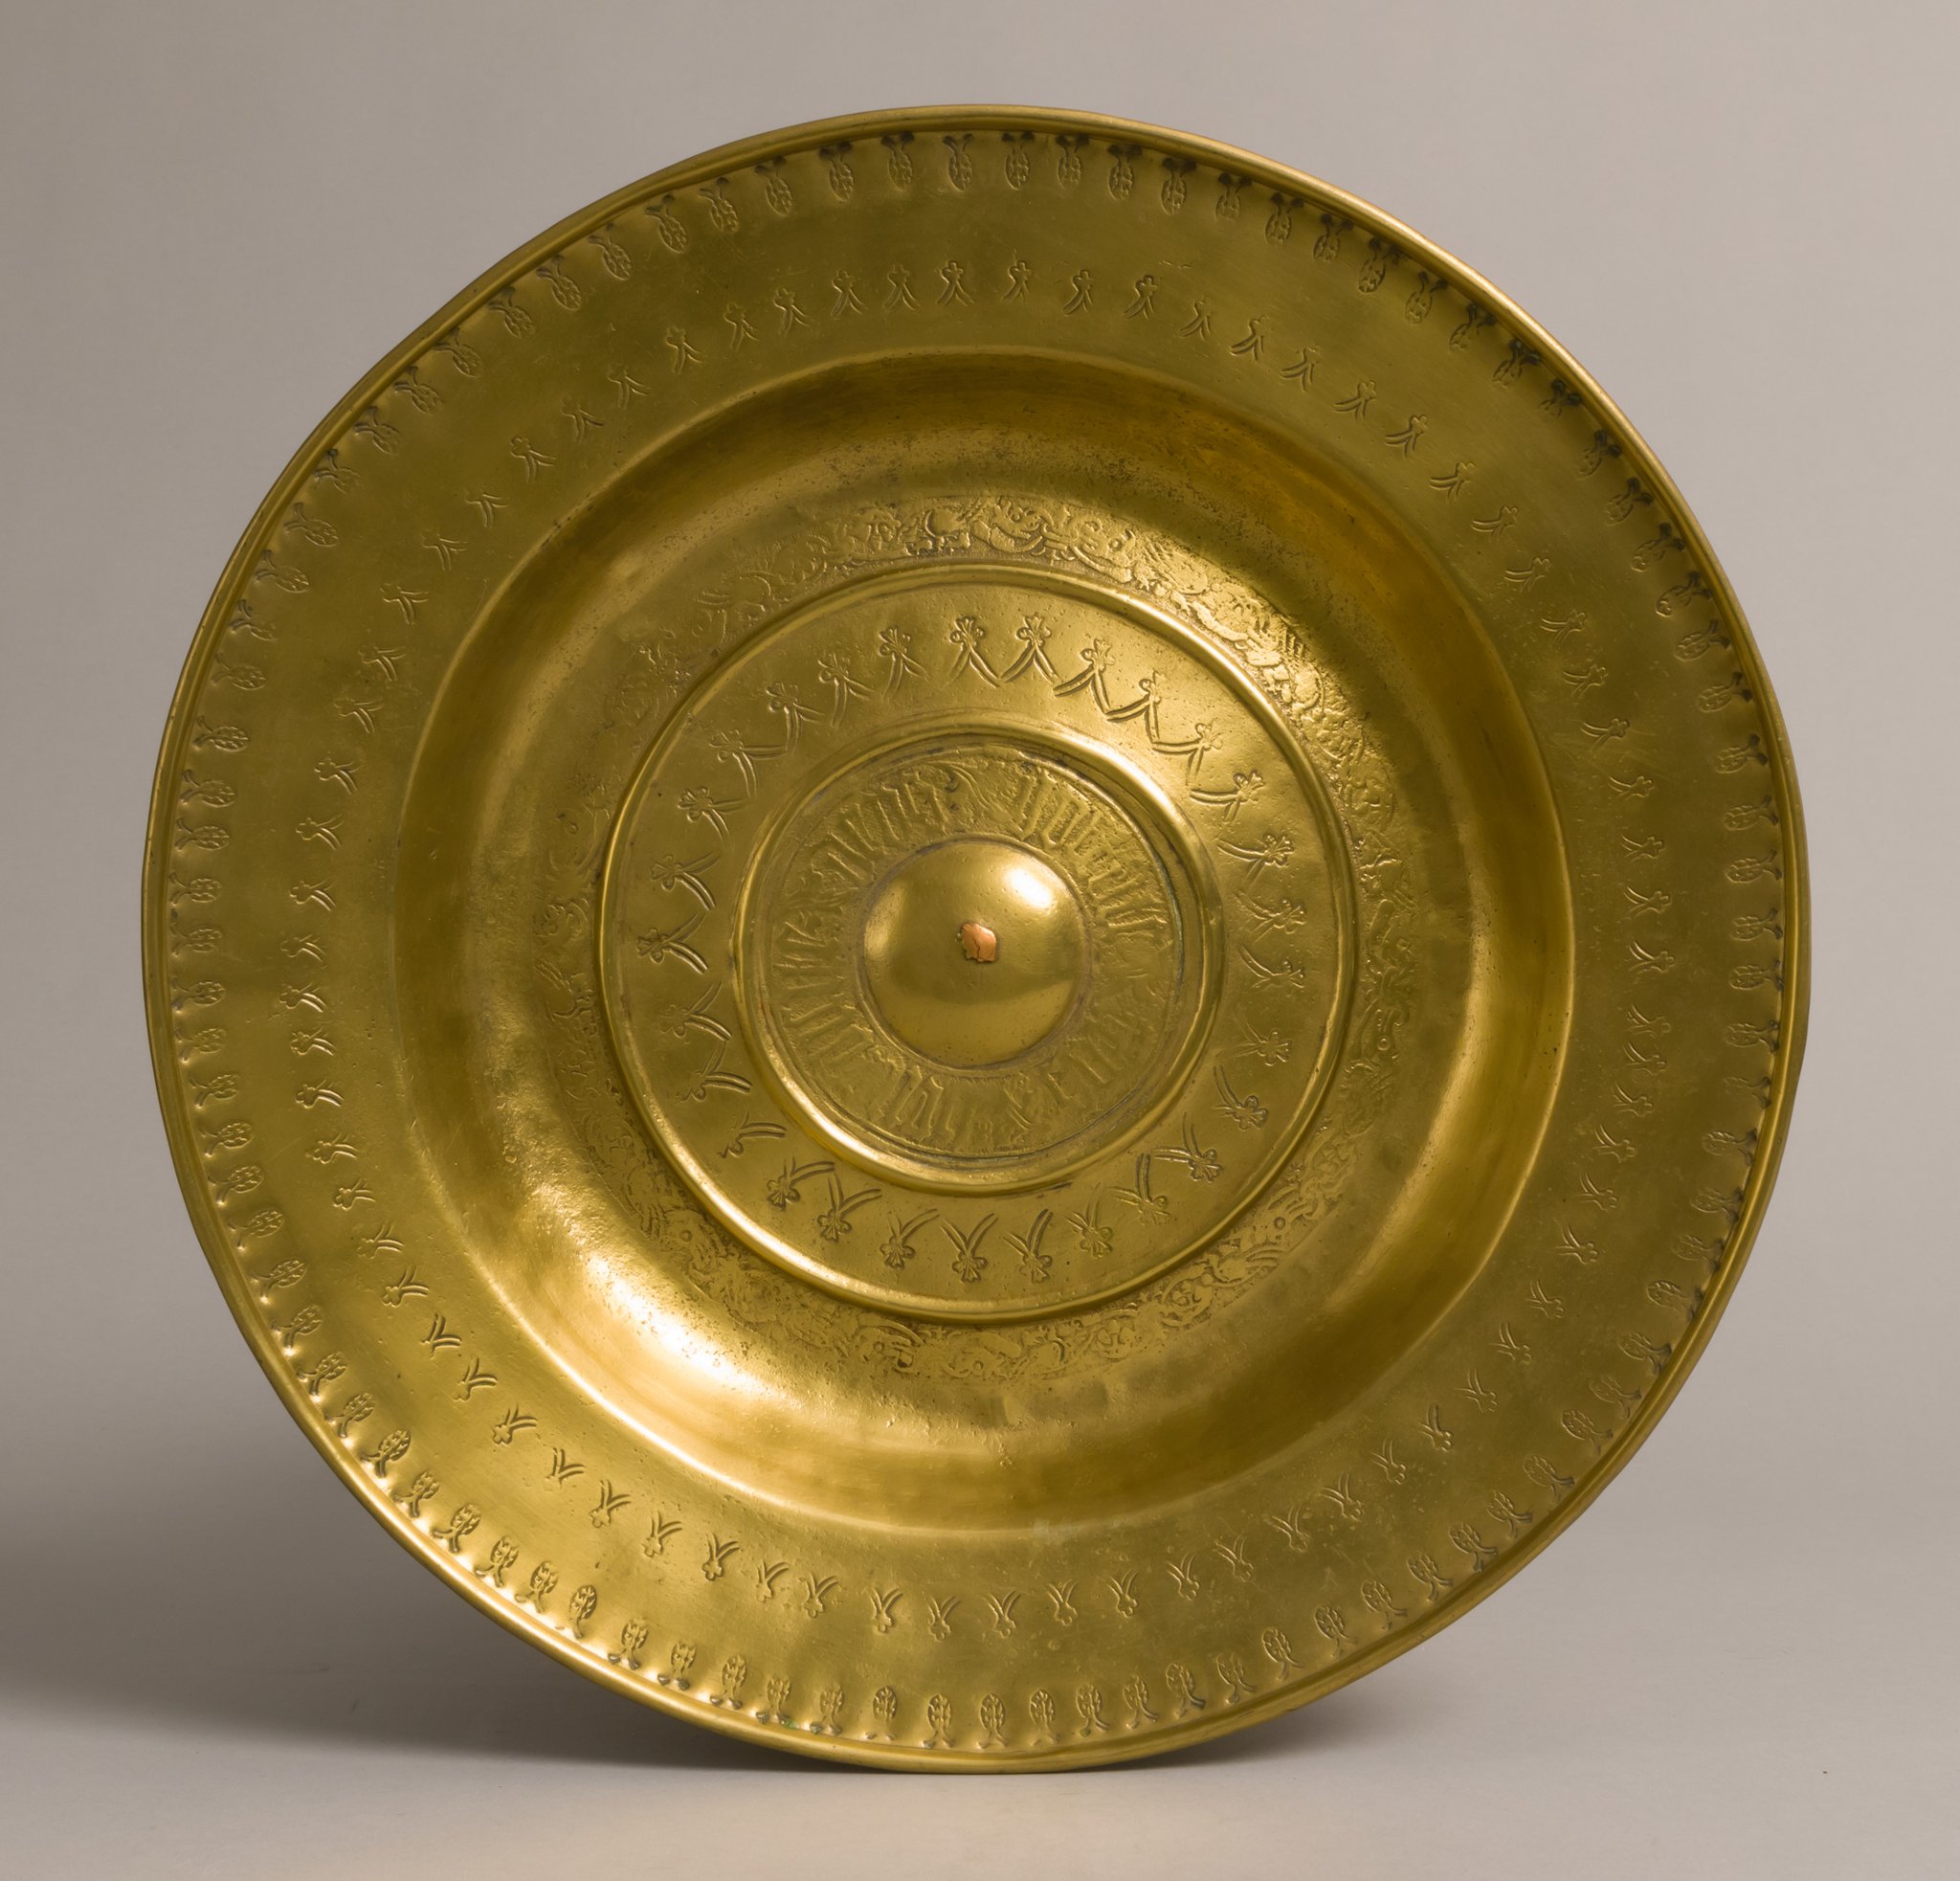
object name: dish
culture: german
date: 1501-1533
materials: brass